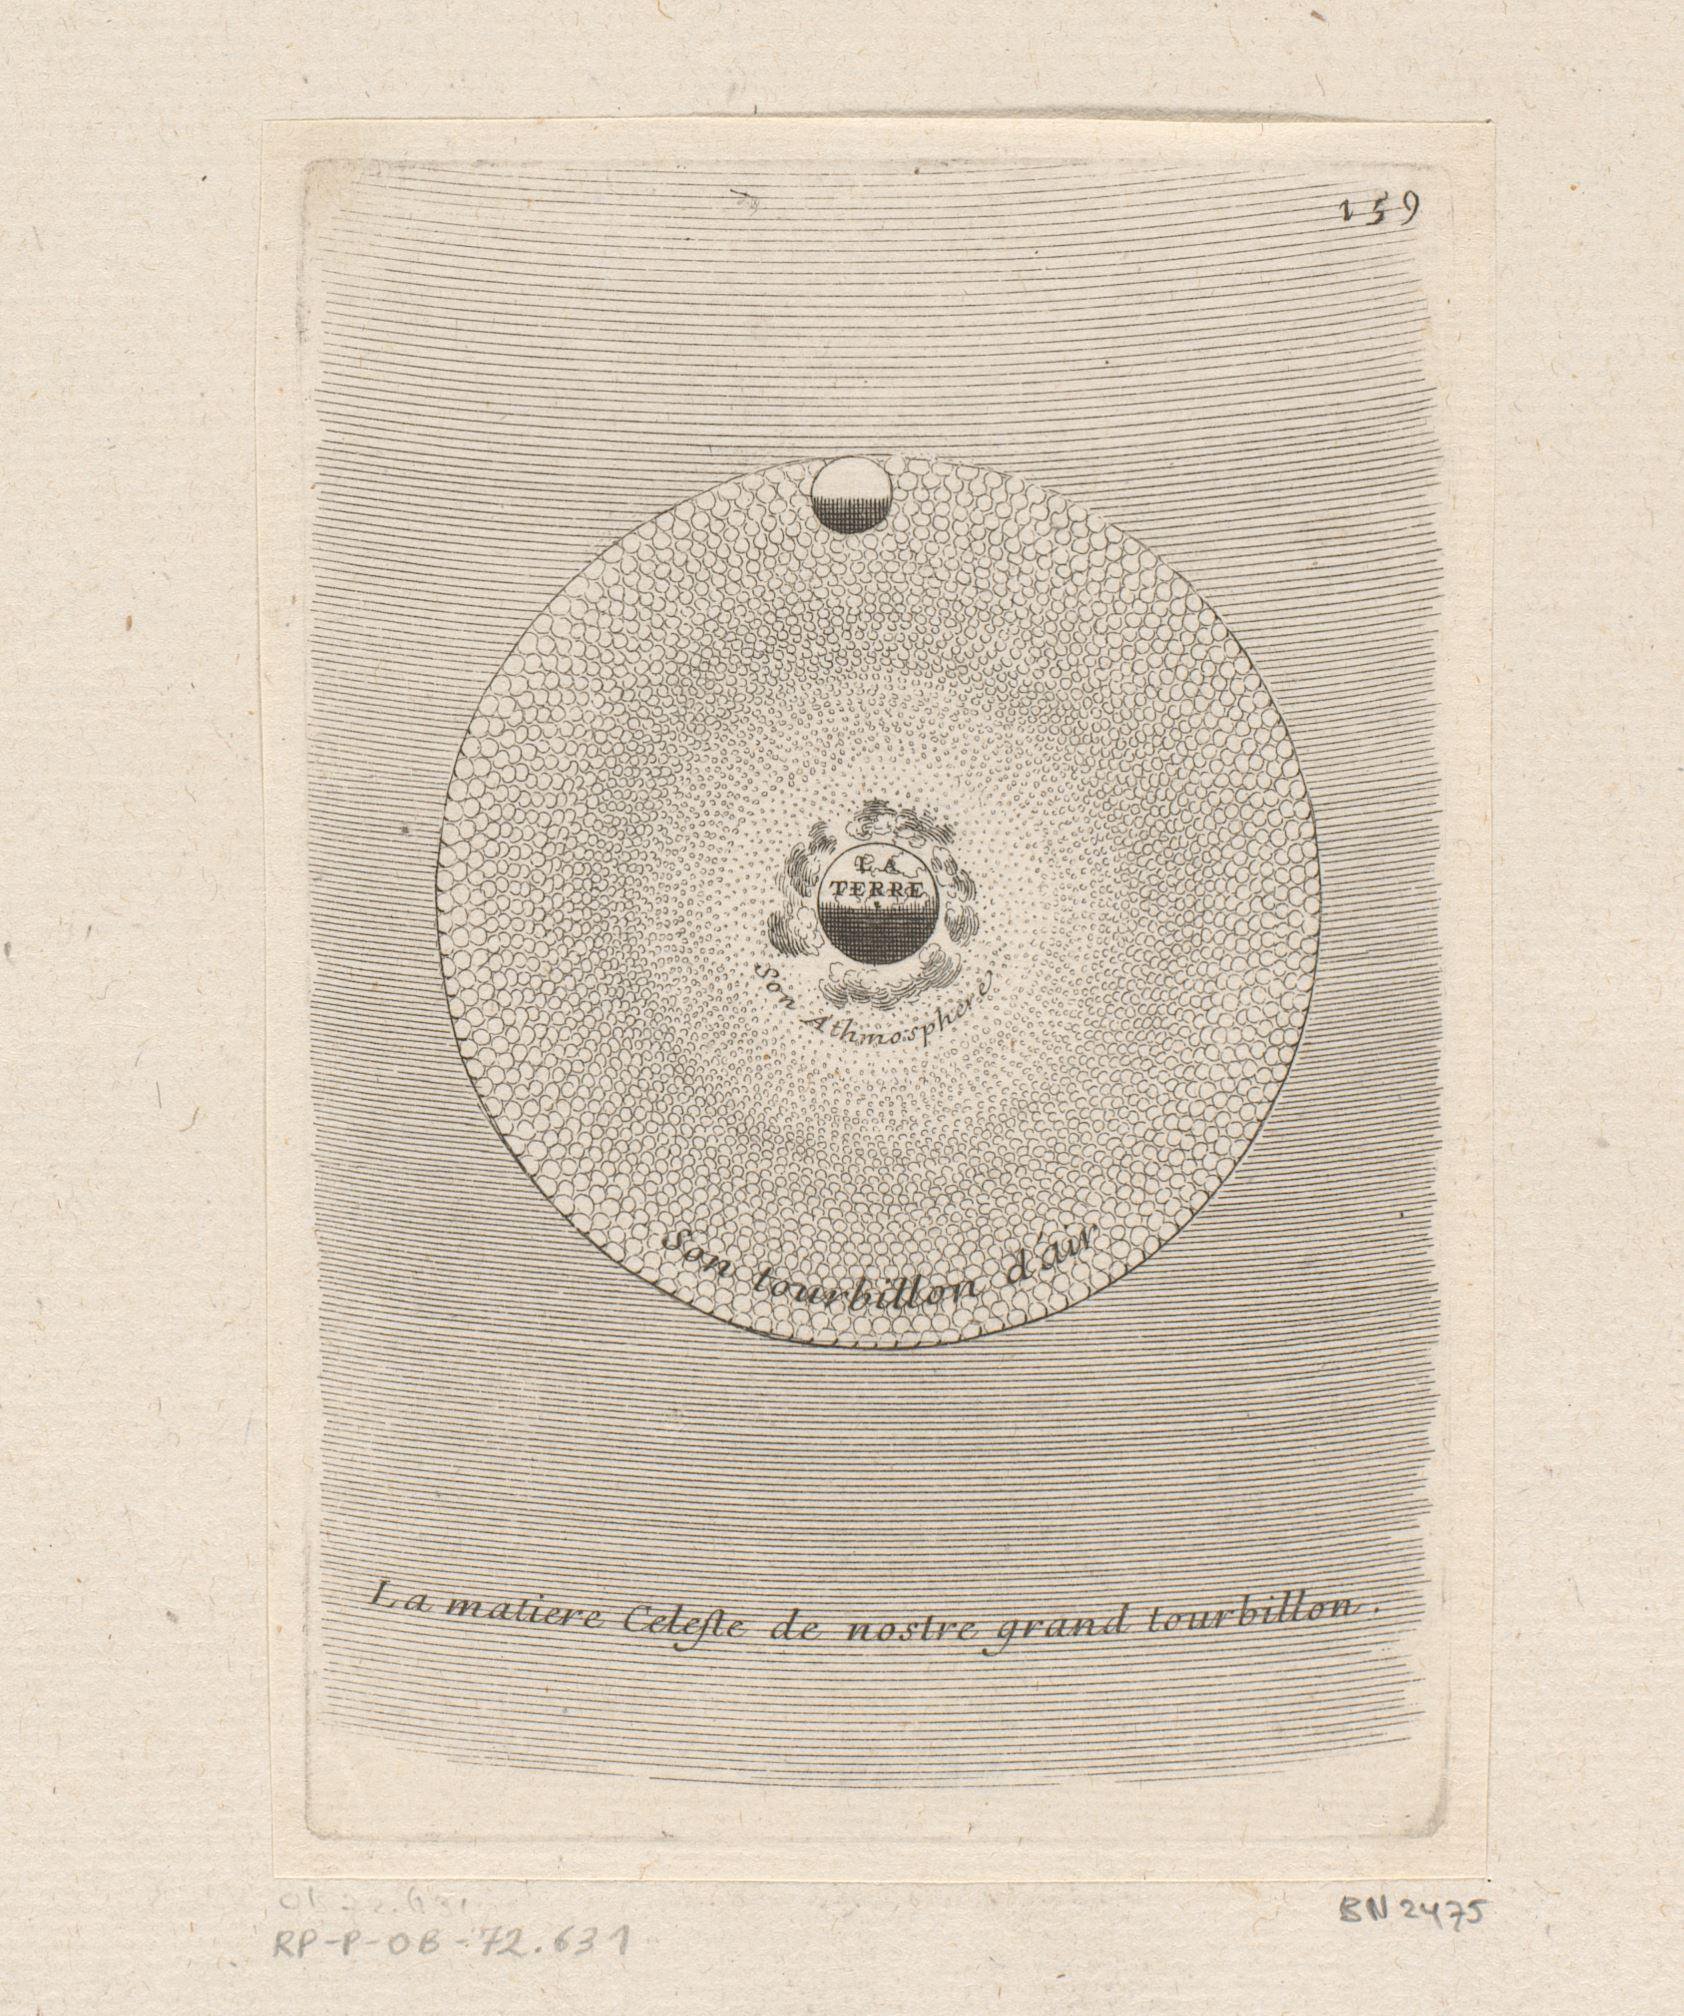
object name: print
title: Aarde en de Maan met luchtstroming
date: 1706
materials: paper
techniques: etching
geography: france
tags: earth, world as celestial body, moon as celestial body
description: Prent uit: Leclerc, Sébastien. Nouveau systeme du monde conforme à l'Ecriture sainte. Où les phénomènes sont expliquez sans excentricité de mouvement (...). Paris: Pierre Giffart, 1706.